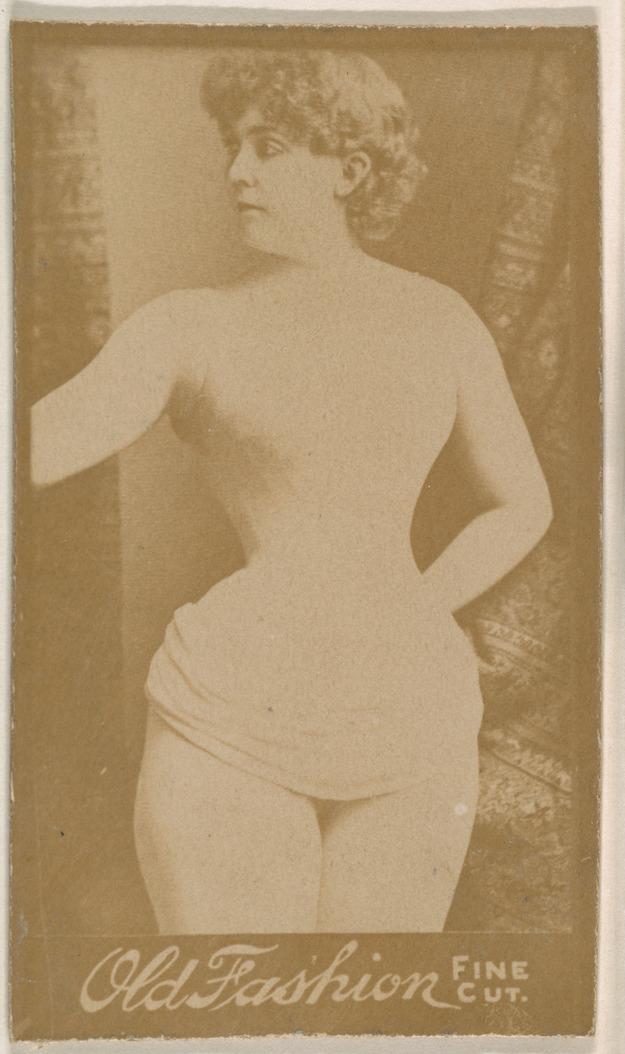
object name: photograph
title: Portrait of actress, from the Actresses series (N664) promoting Old Fashion Fine Cut Tobacco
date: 1888-1890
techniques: albumen silver print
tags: portraits,women,actresses